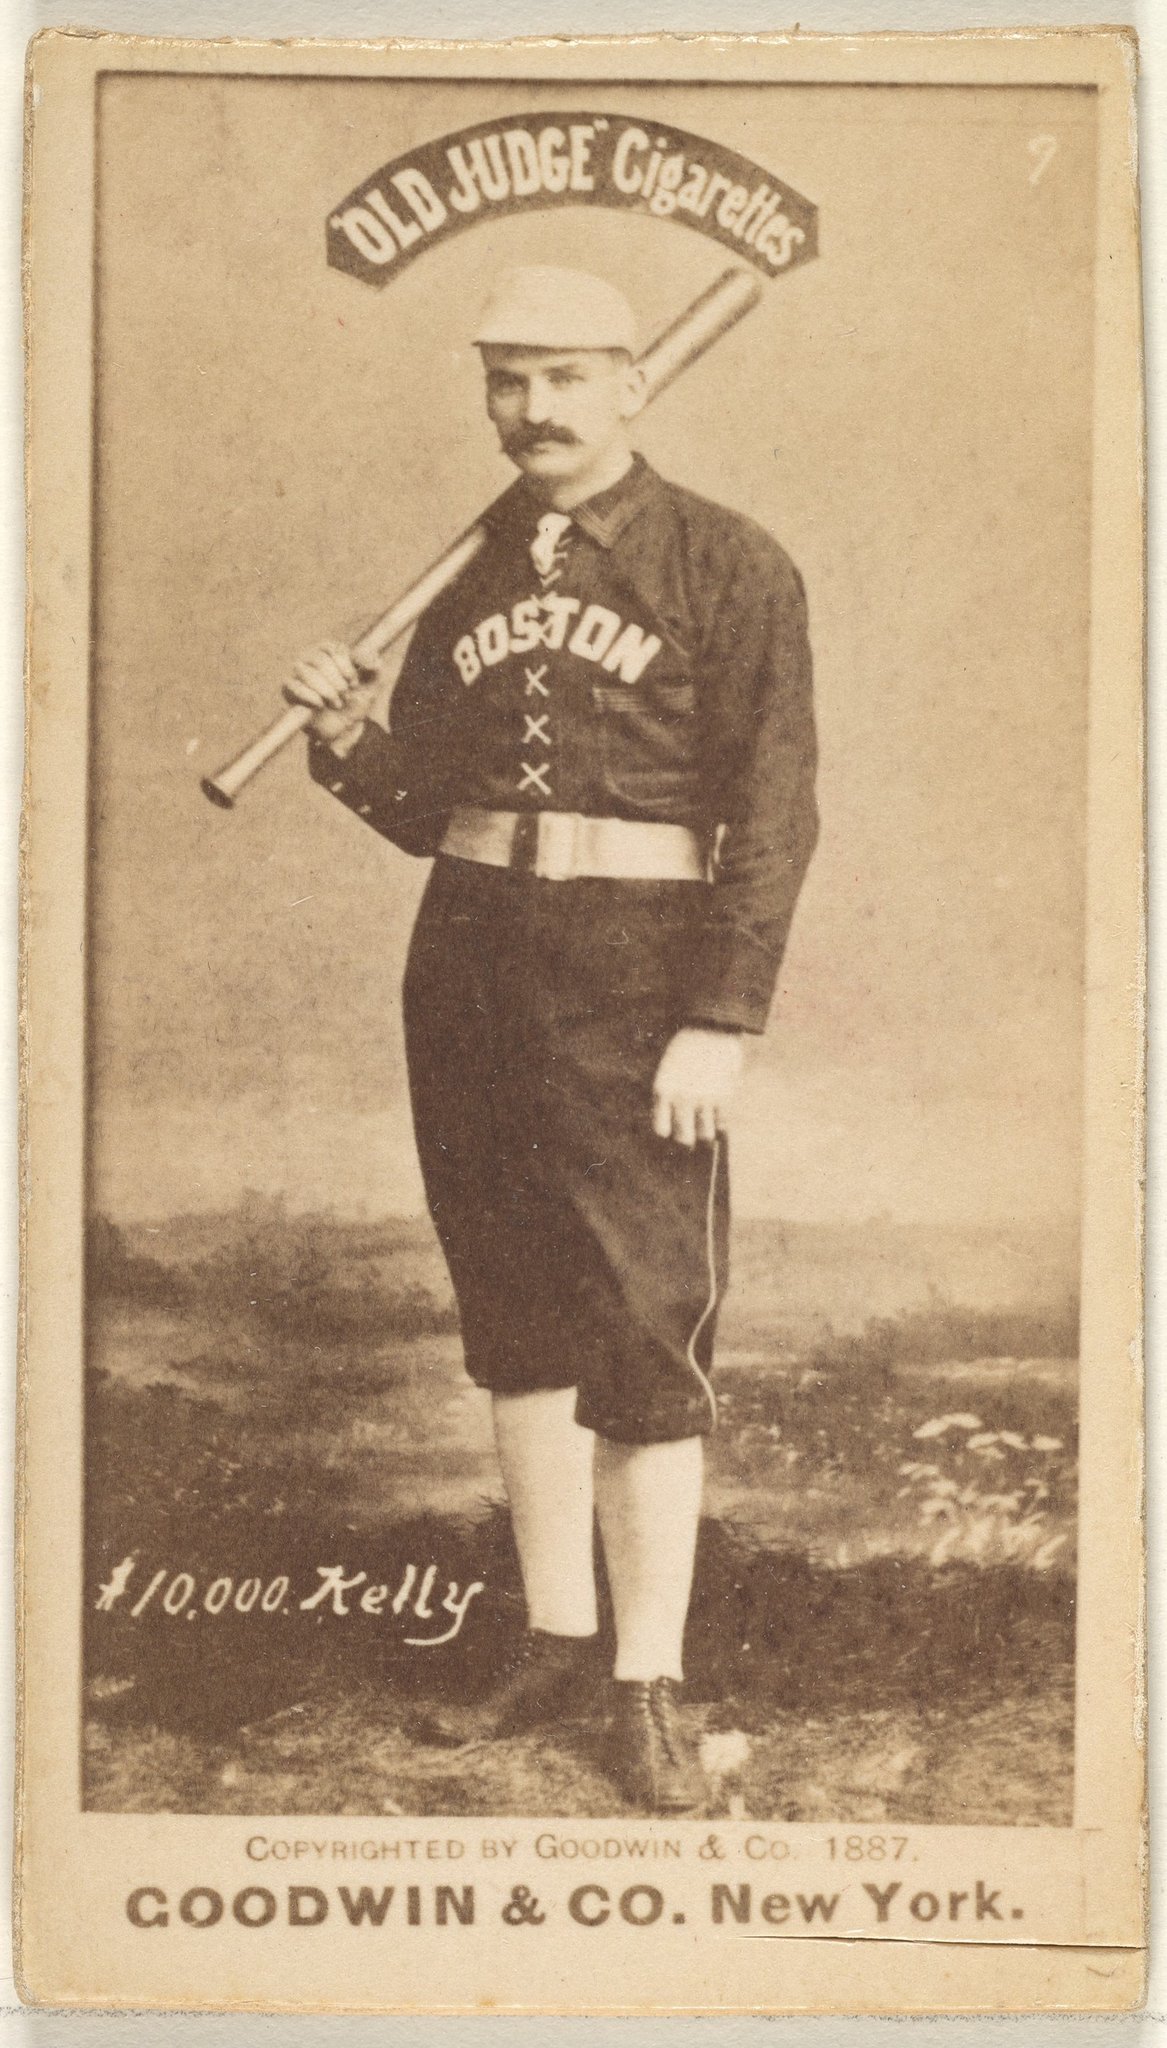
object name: baseball card, photograph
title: "$10,000" Kelly, Boston, from the Old Judge series (N172) for Old Judge Cigarettes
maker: goodwin & company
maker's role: publisher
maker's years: 1850-1950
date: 1887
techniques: albumen silver print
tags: men,baseball,athletes